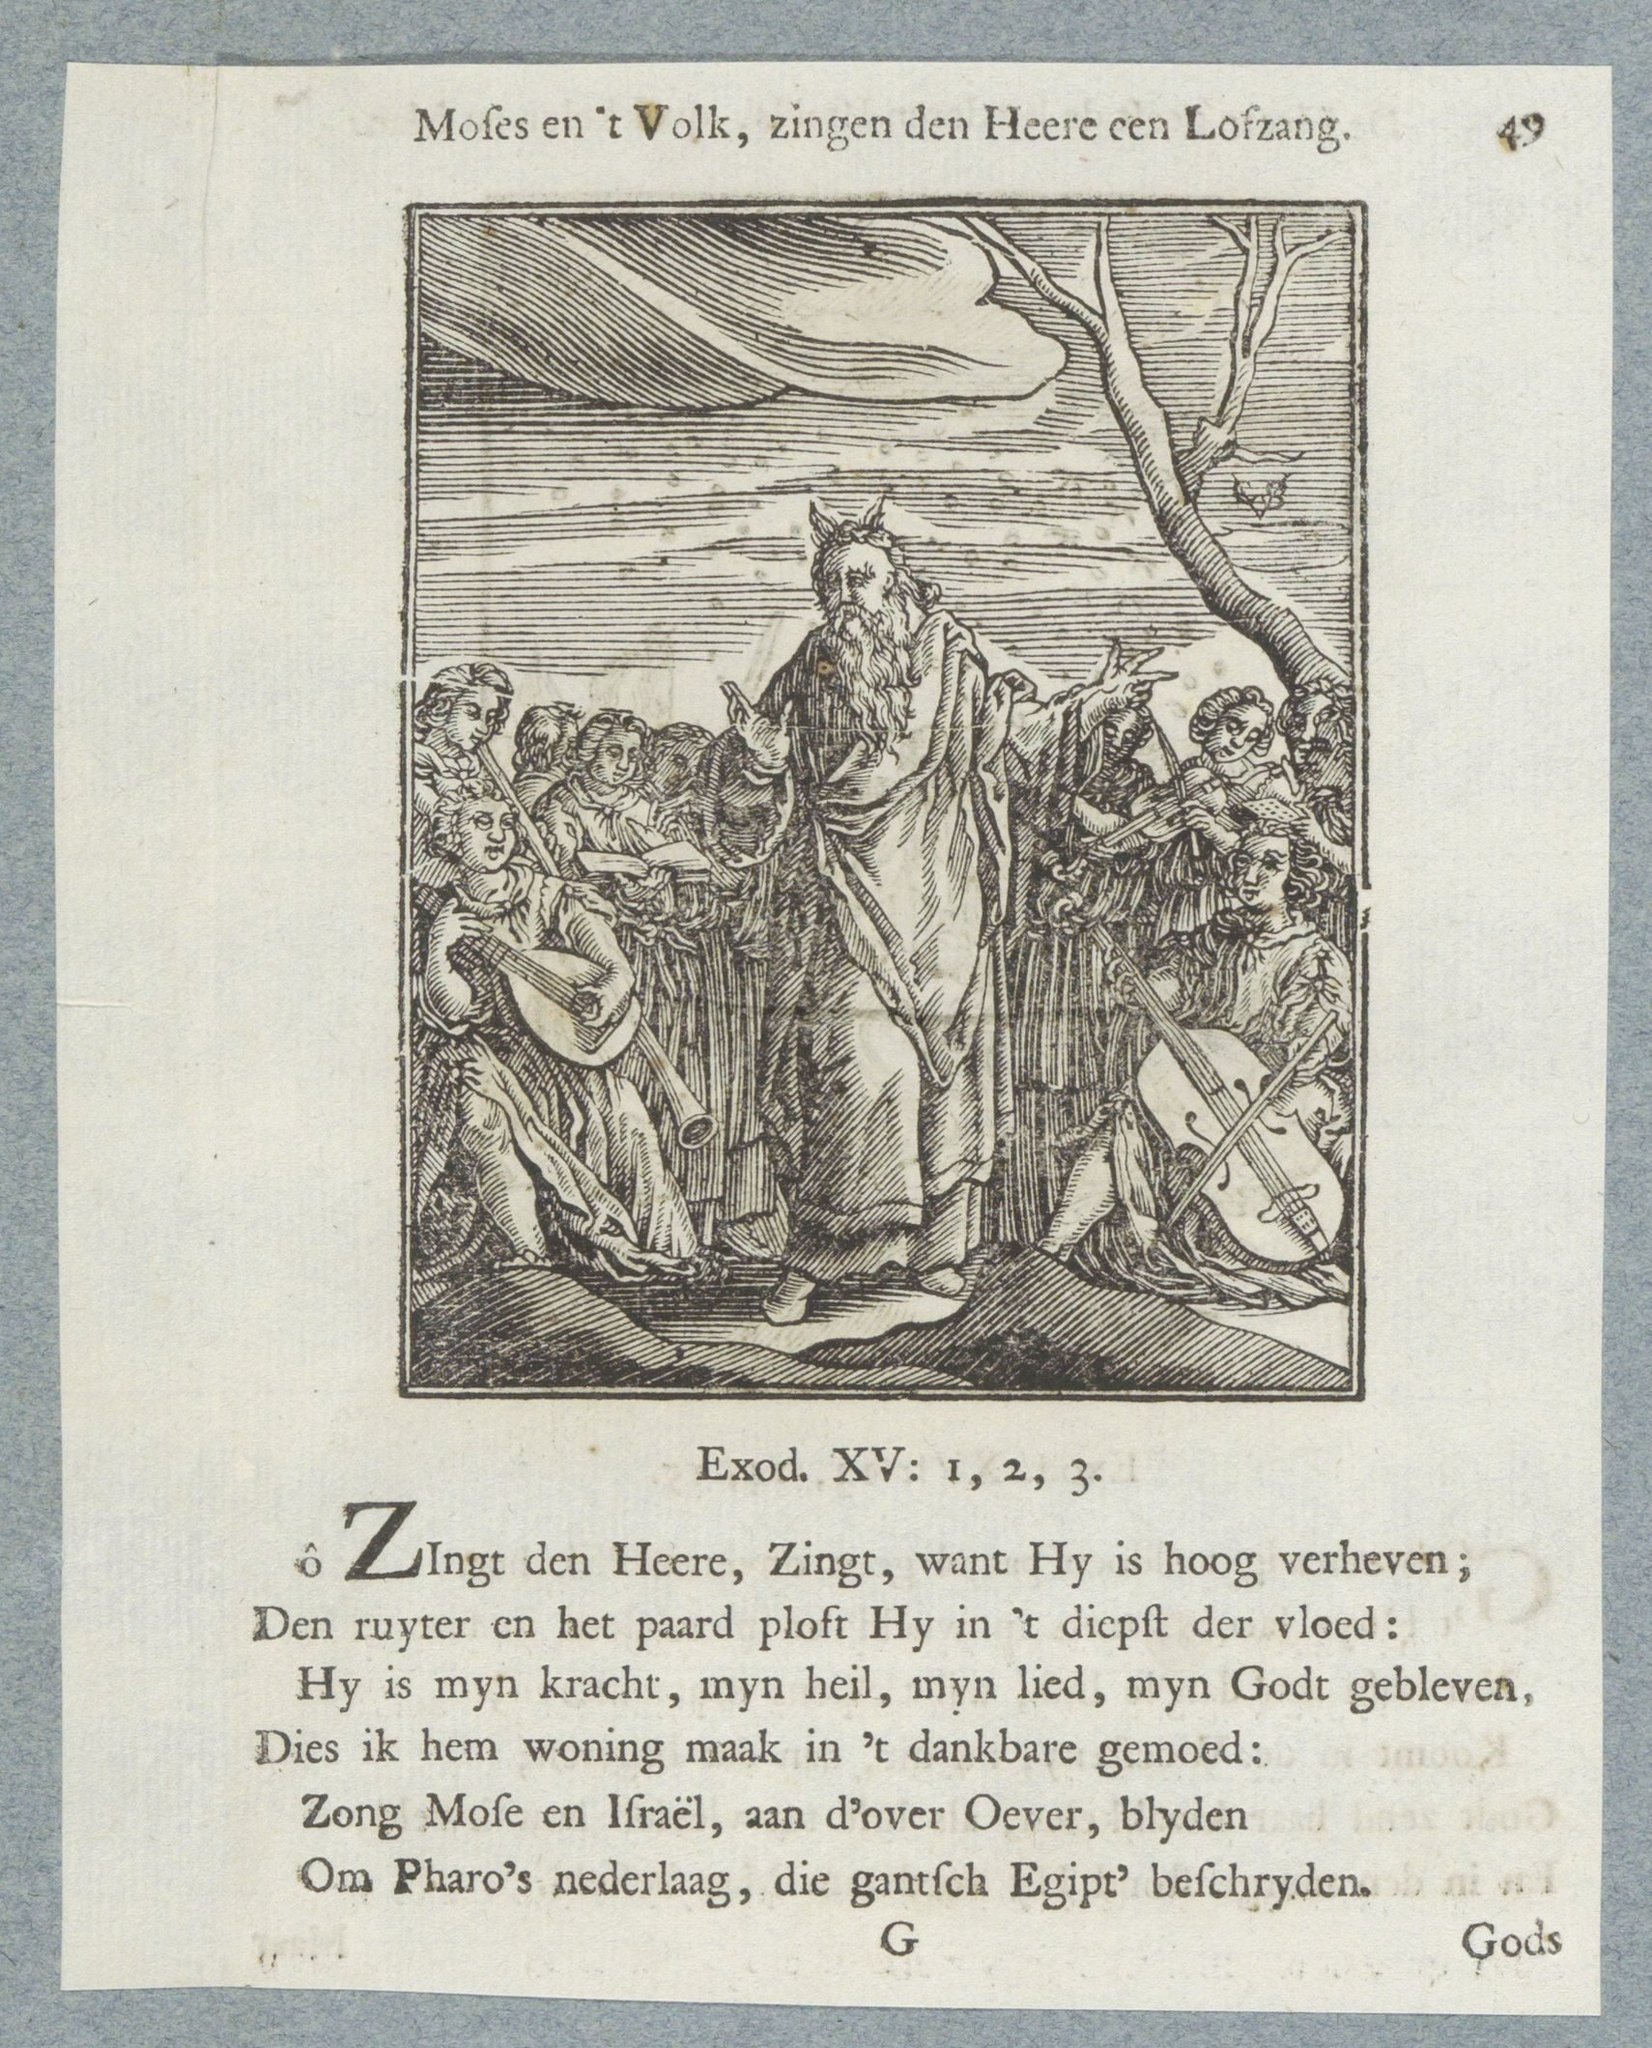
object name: album leaf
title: Mozes en de Israëlieten heffen een danklied aan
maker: jan klooster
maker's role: bookseller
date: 1645-1646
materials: paper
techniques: letterpress printing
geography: amsterdam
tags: after crossing the red sea the israelites rejoice and praise god (exodus 15:1-21)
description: De prent is afkomstig uit: Bybels Lusthof. Amsterdam, J. Klooster, 1740. De prent werd gemaakt voor de uitgaven van P.J. Paets uit Amsterdam. Ze komt in ieder geval voor in: Bibels Tresoor ofte der zielen lusthof. Amsterdam, P.J. Paets, 1646. Mogelijk staat ze ook in: Historien ende Prophetien. [Amsterdam], P.J. Paets, 1645.